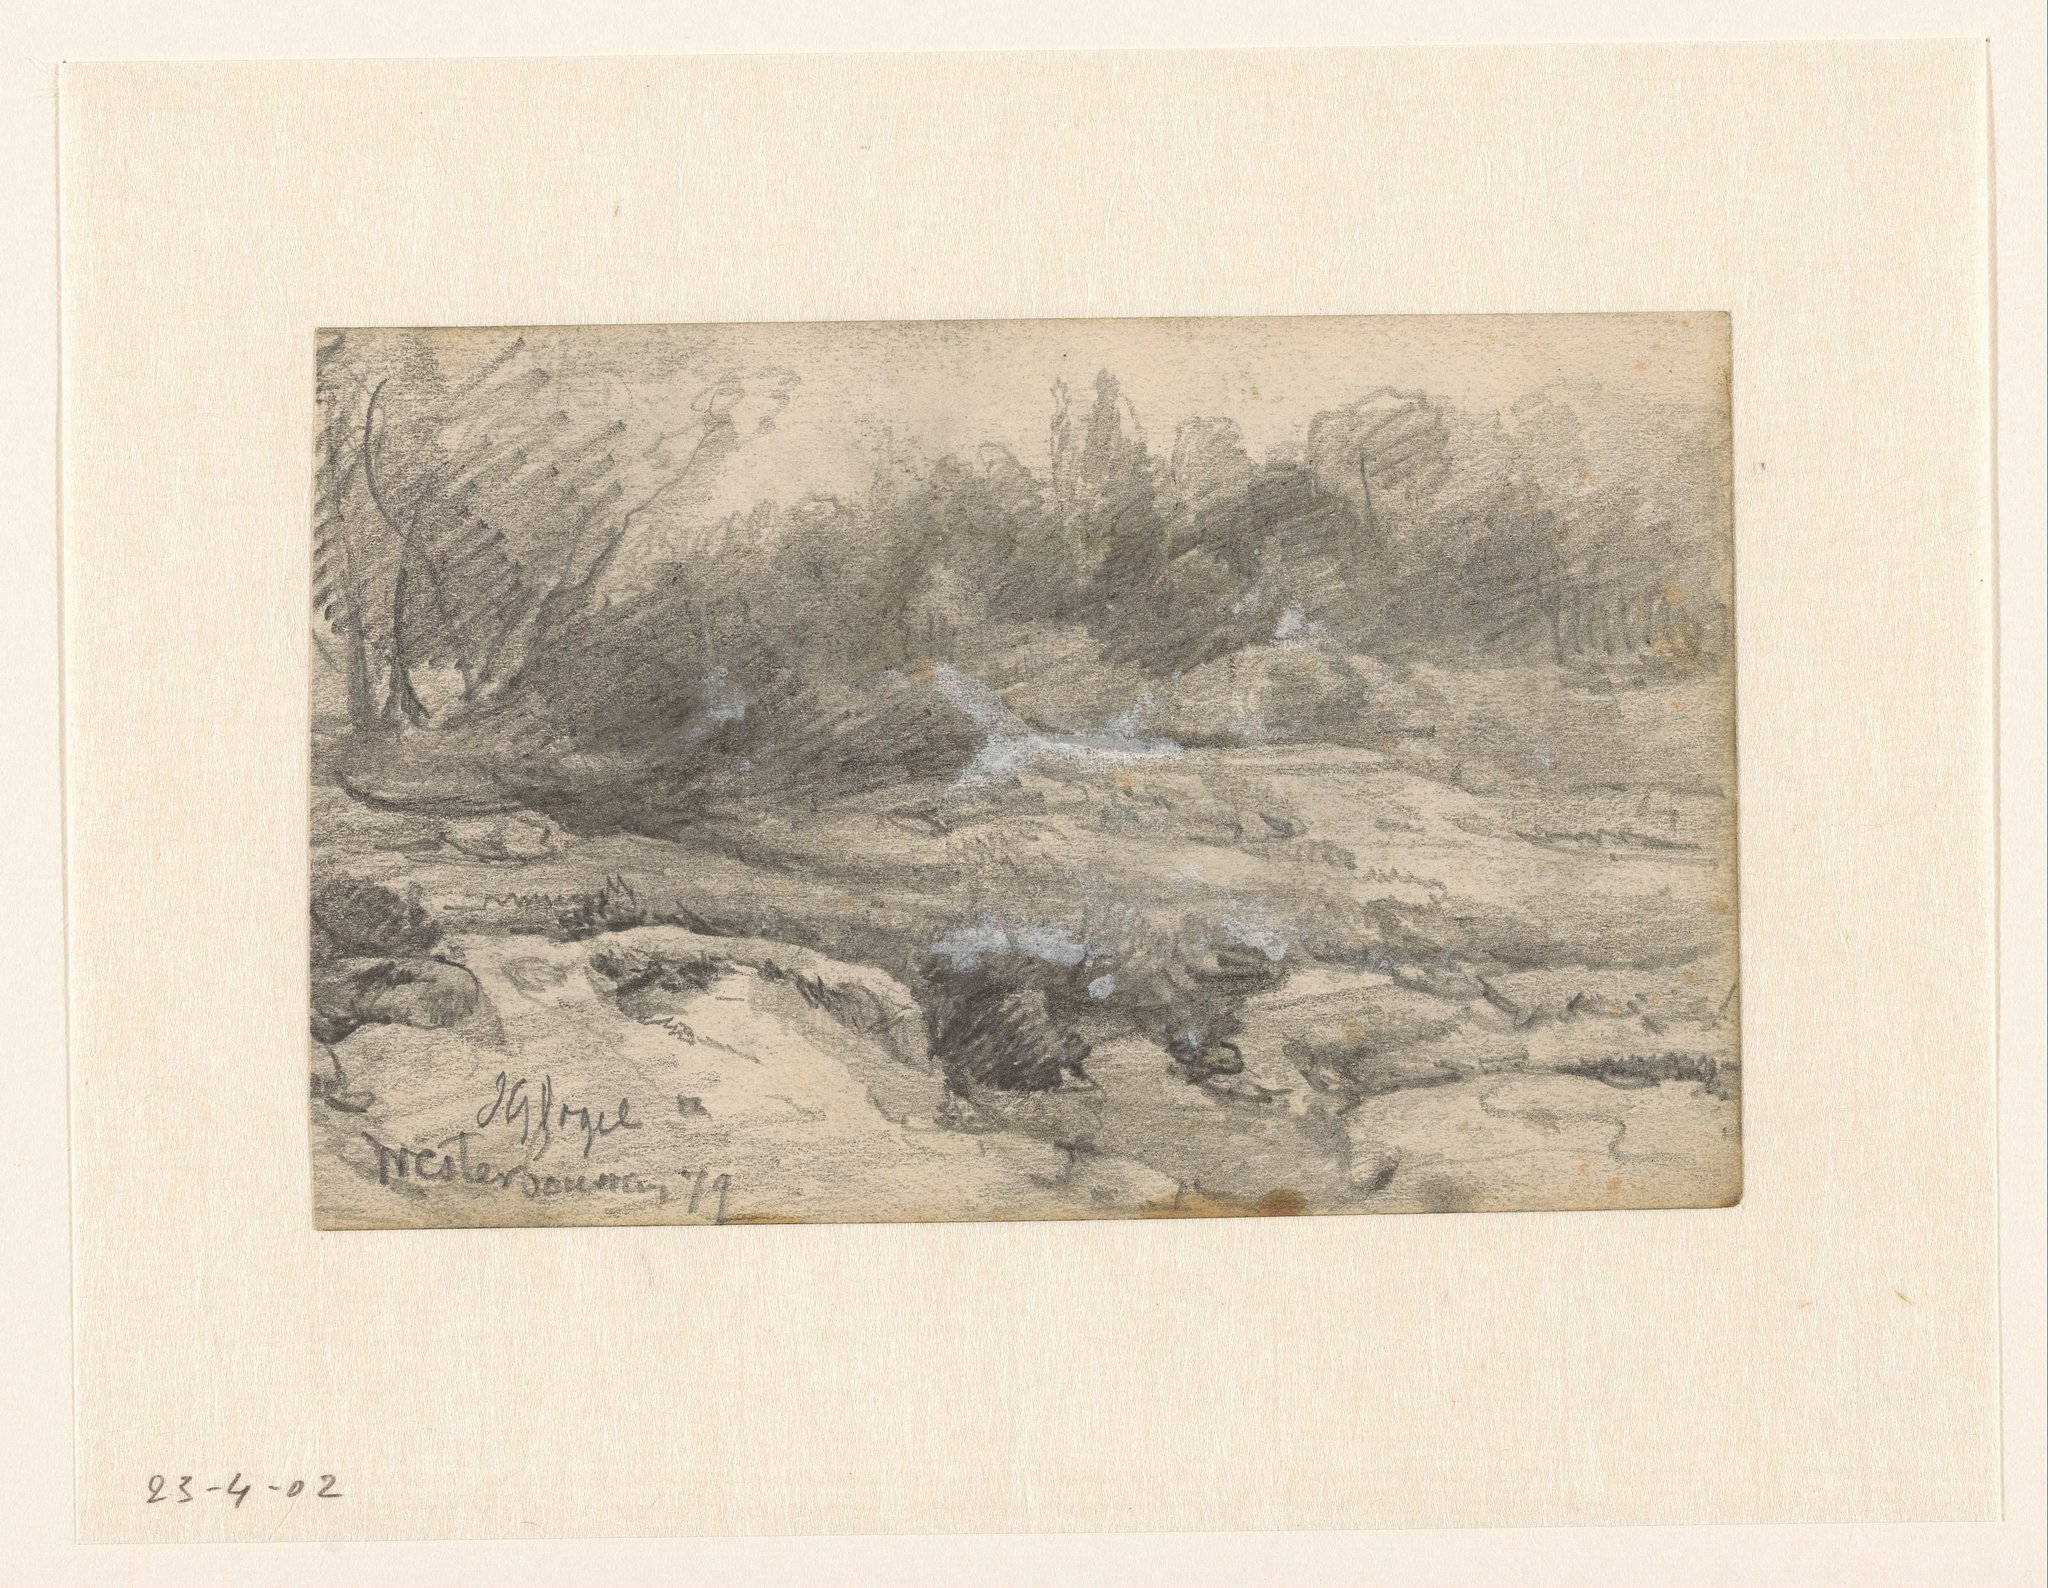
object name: drawing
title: Landschap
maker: johannes gijsbert vogel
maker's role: draughtsman, painter, print maker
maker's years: 1828-1915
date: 1879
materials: chalk, paper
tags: landscapes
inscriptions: inscription: ‘Wester[bouman ?]’